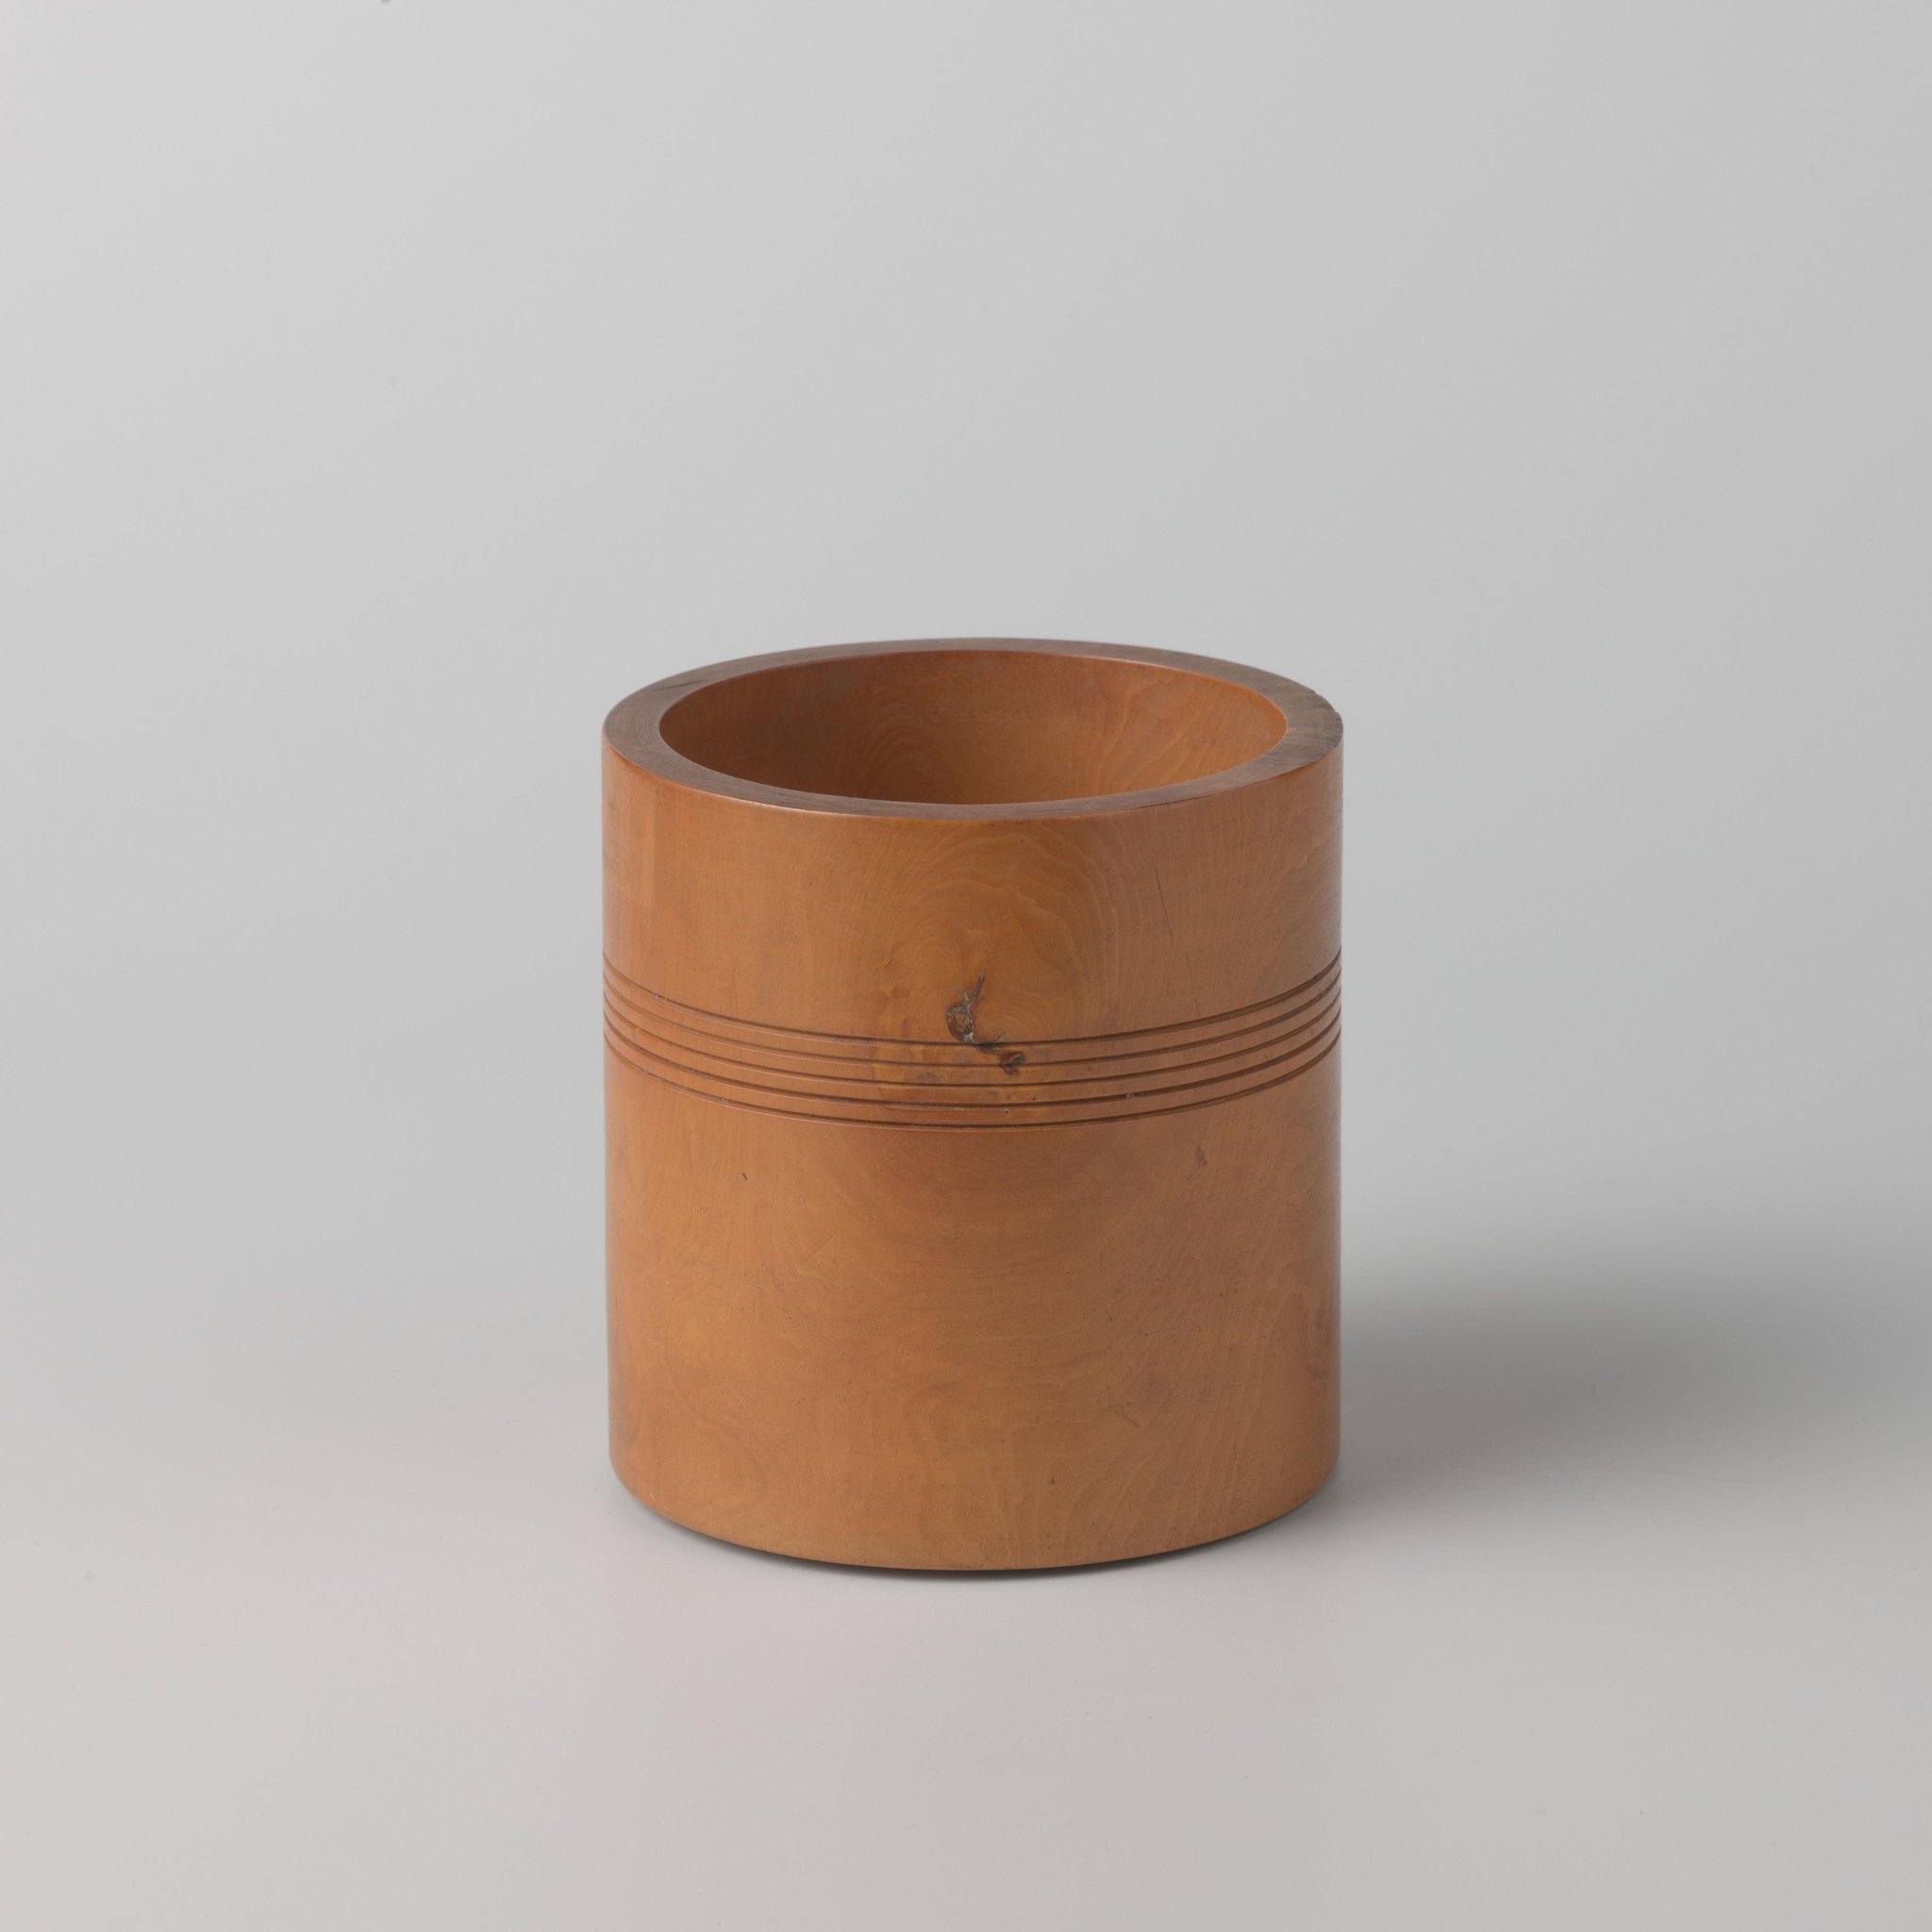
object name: inhoudsmaat droge waren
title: Cilindrische inhoudsmaat van 1/2 (?) l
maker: Anonymous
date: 1825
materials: wood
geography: netherlands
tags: netherlands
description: Gedraaide houten inhoudsmaat. Aan de buitenzijde v.z.v. 5 cirkelvormige groeven (5 wijst op 5 deciliter); verder geen opschriften, stempels of inhoudsaanduiding.